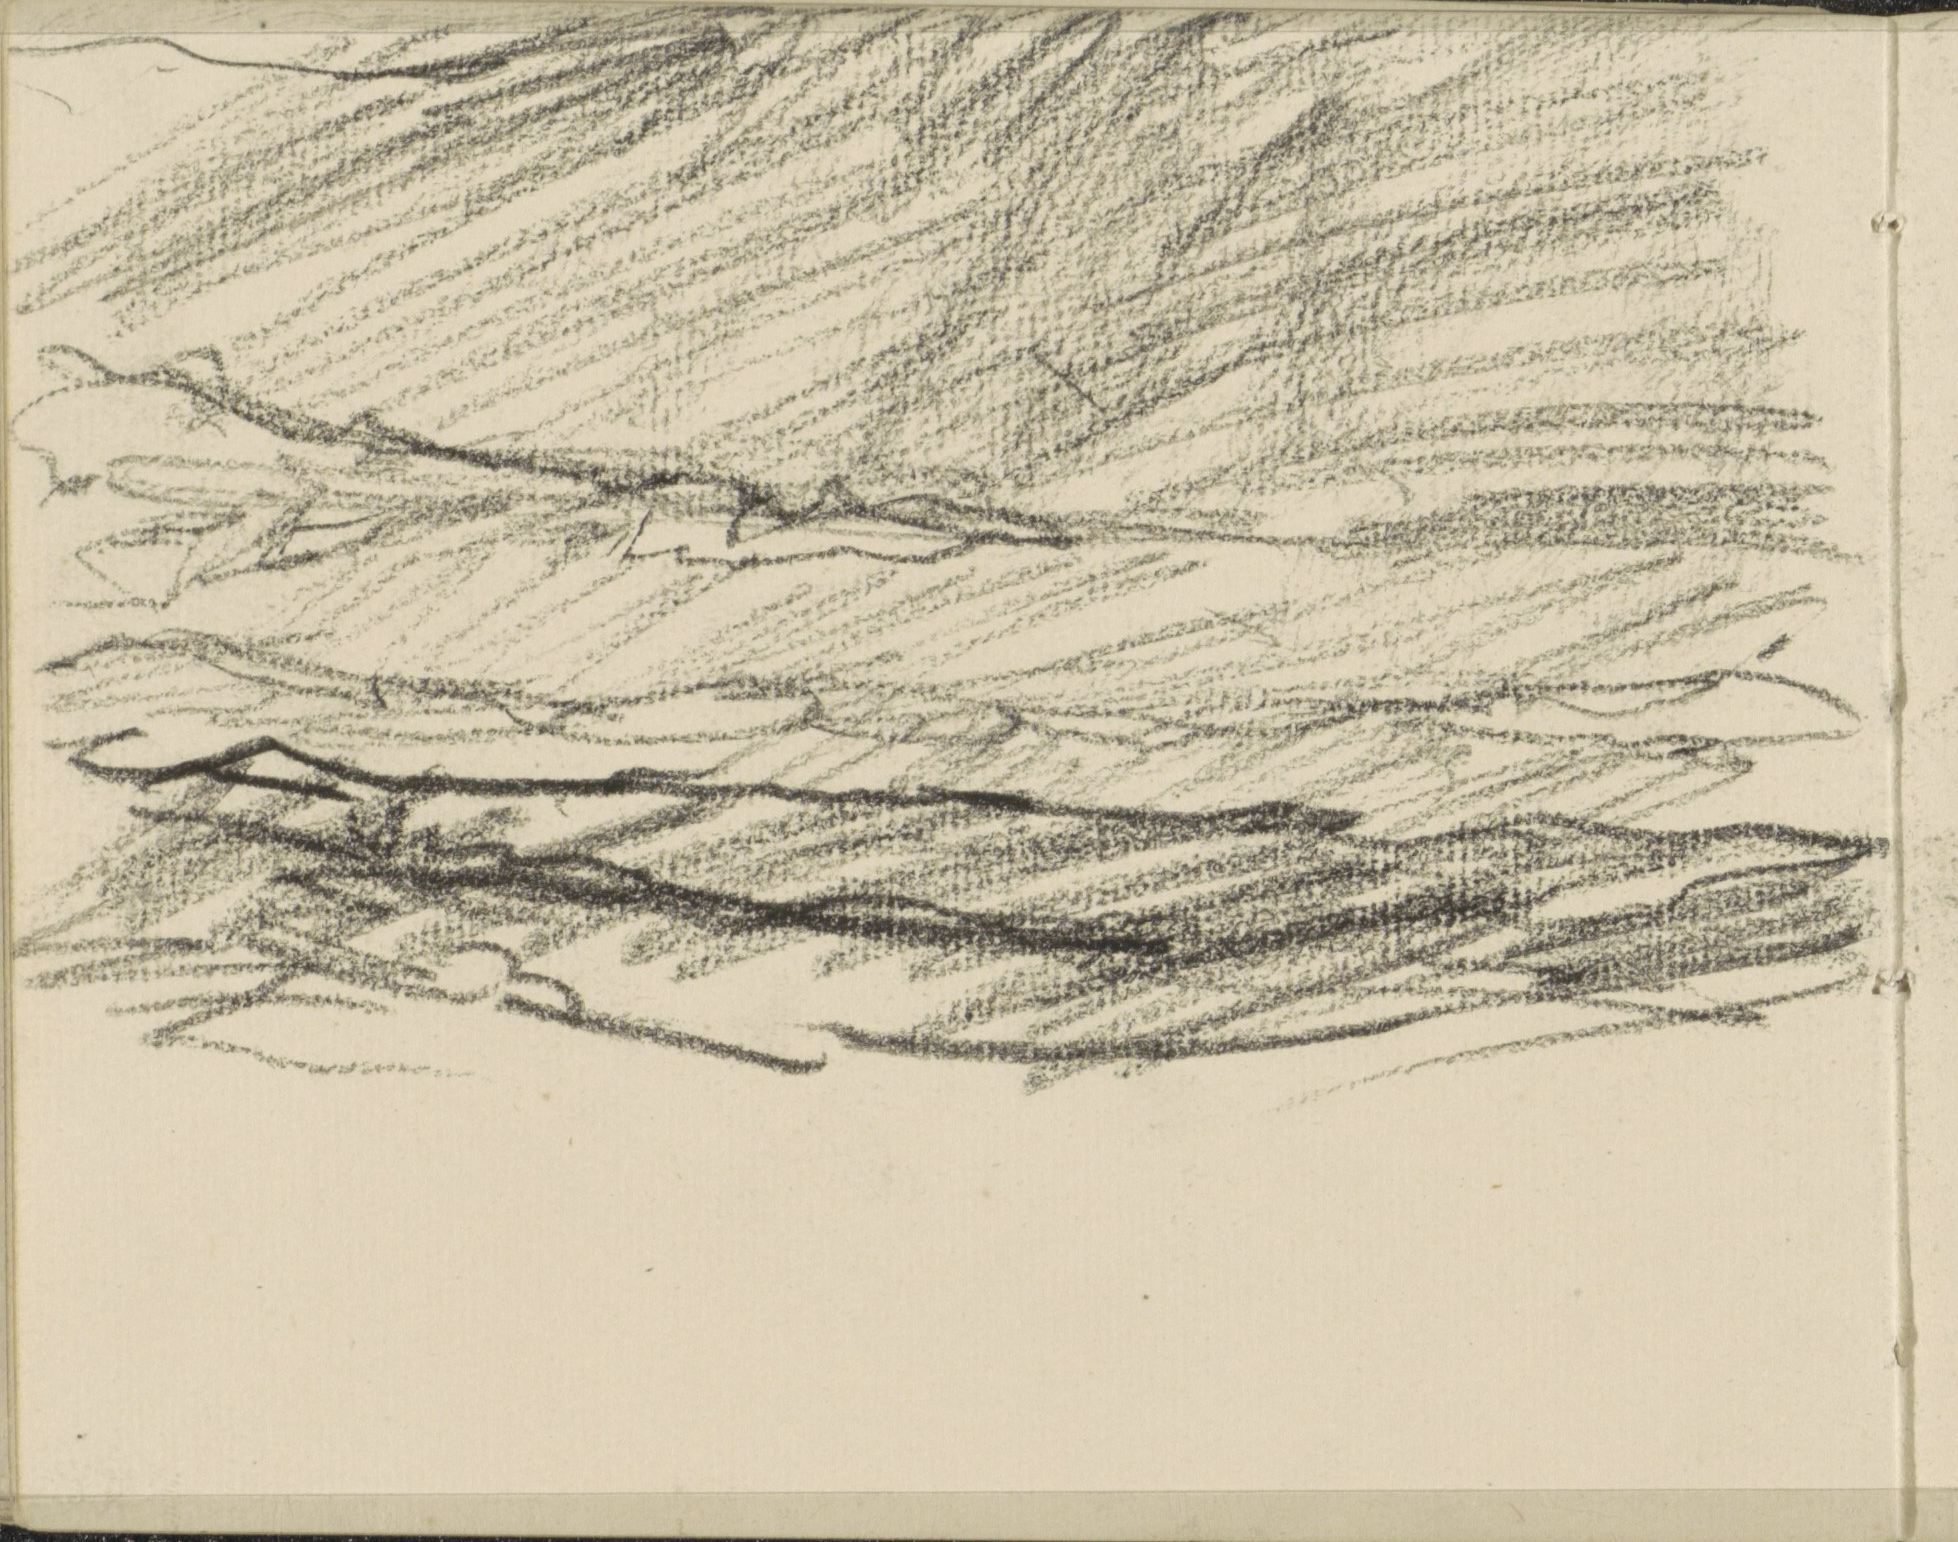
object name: sketchbook leaf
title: Landschap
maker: george hendrik breitner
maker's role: draughtsman, painter, print maker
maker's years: 1857-1923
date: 1885-1898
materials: chalk, paper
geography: ommen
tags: landscapes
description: Pagina 49 uit een schetsboek met 32 bladen.